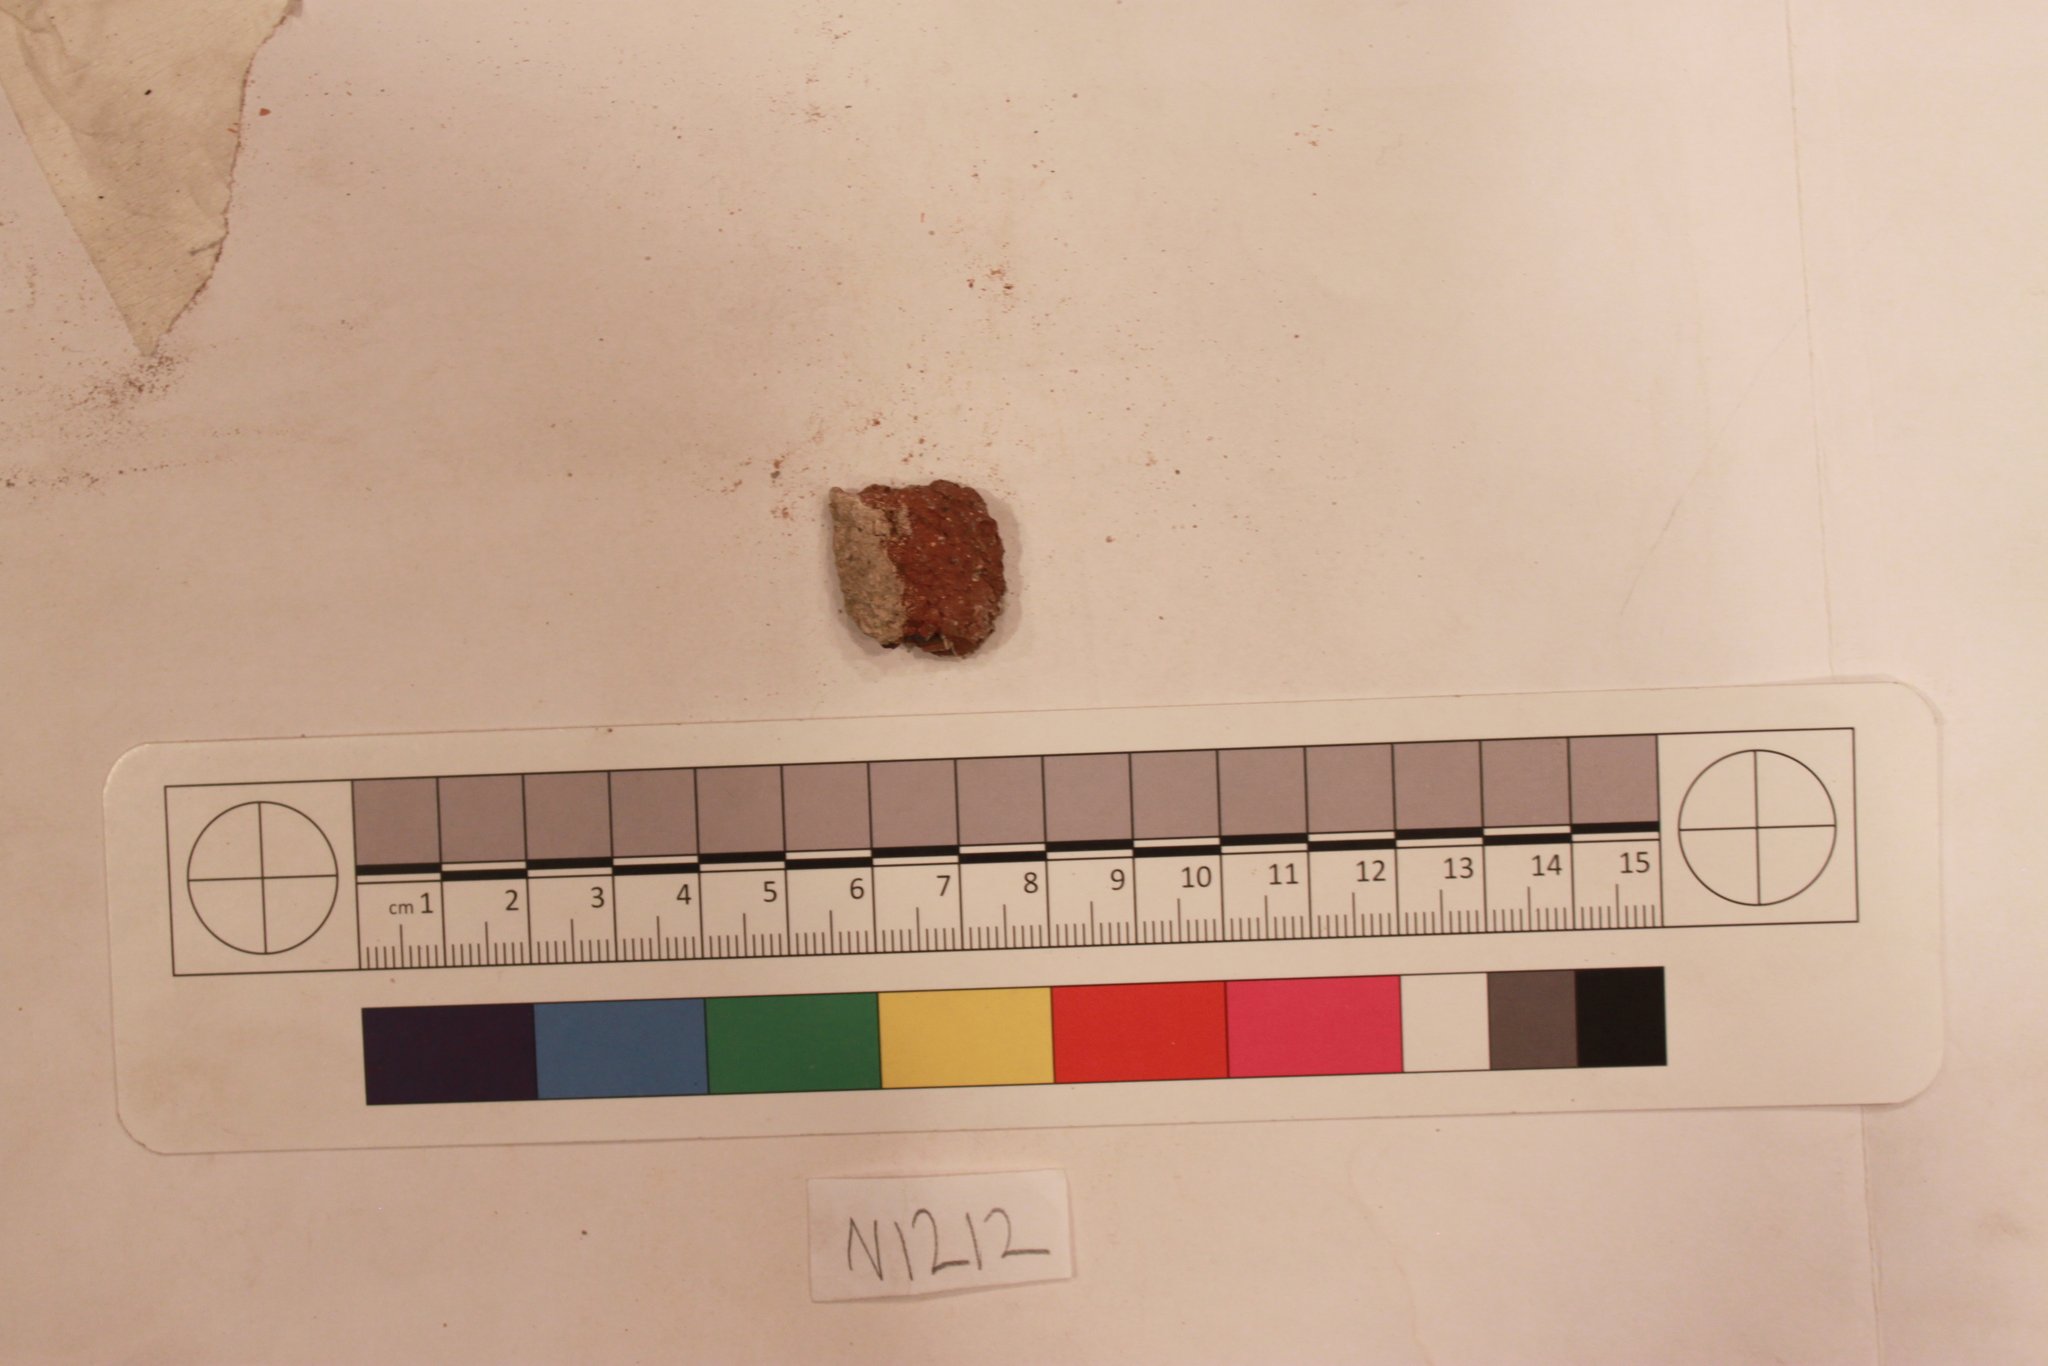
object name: fragment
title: Stucco Fragment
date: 701-1200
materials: plaster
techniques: carving, painting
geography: iran